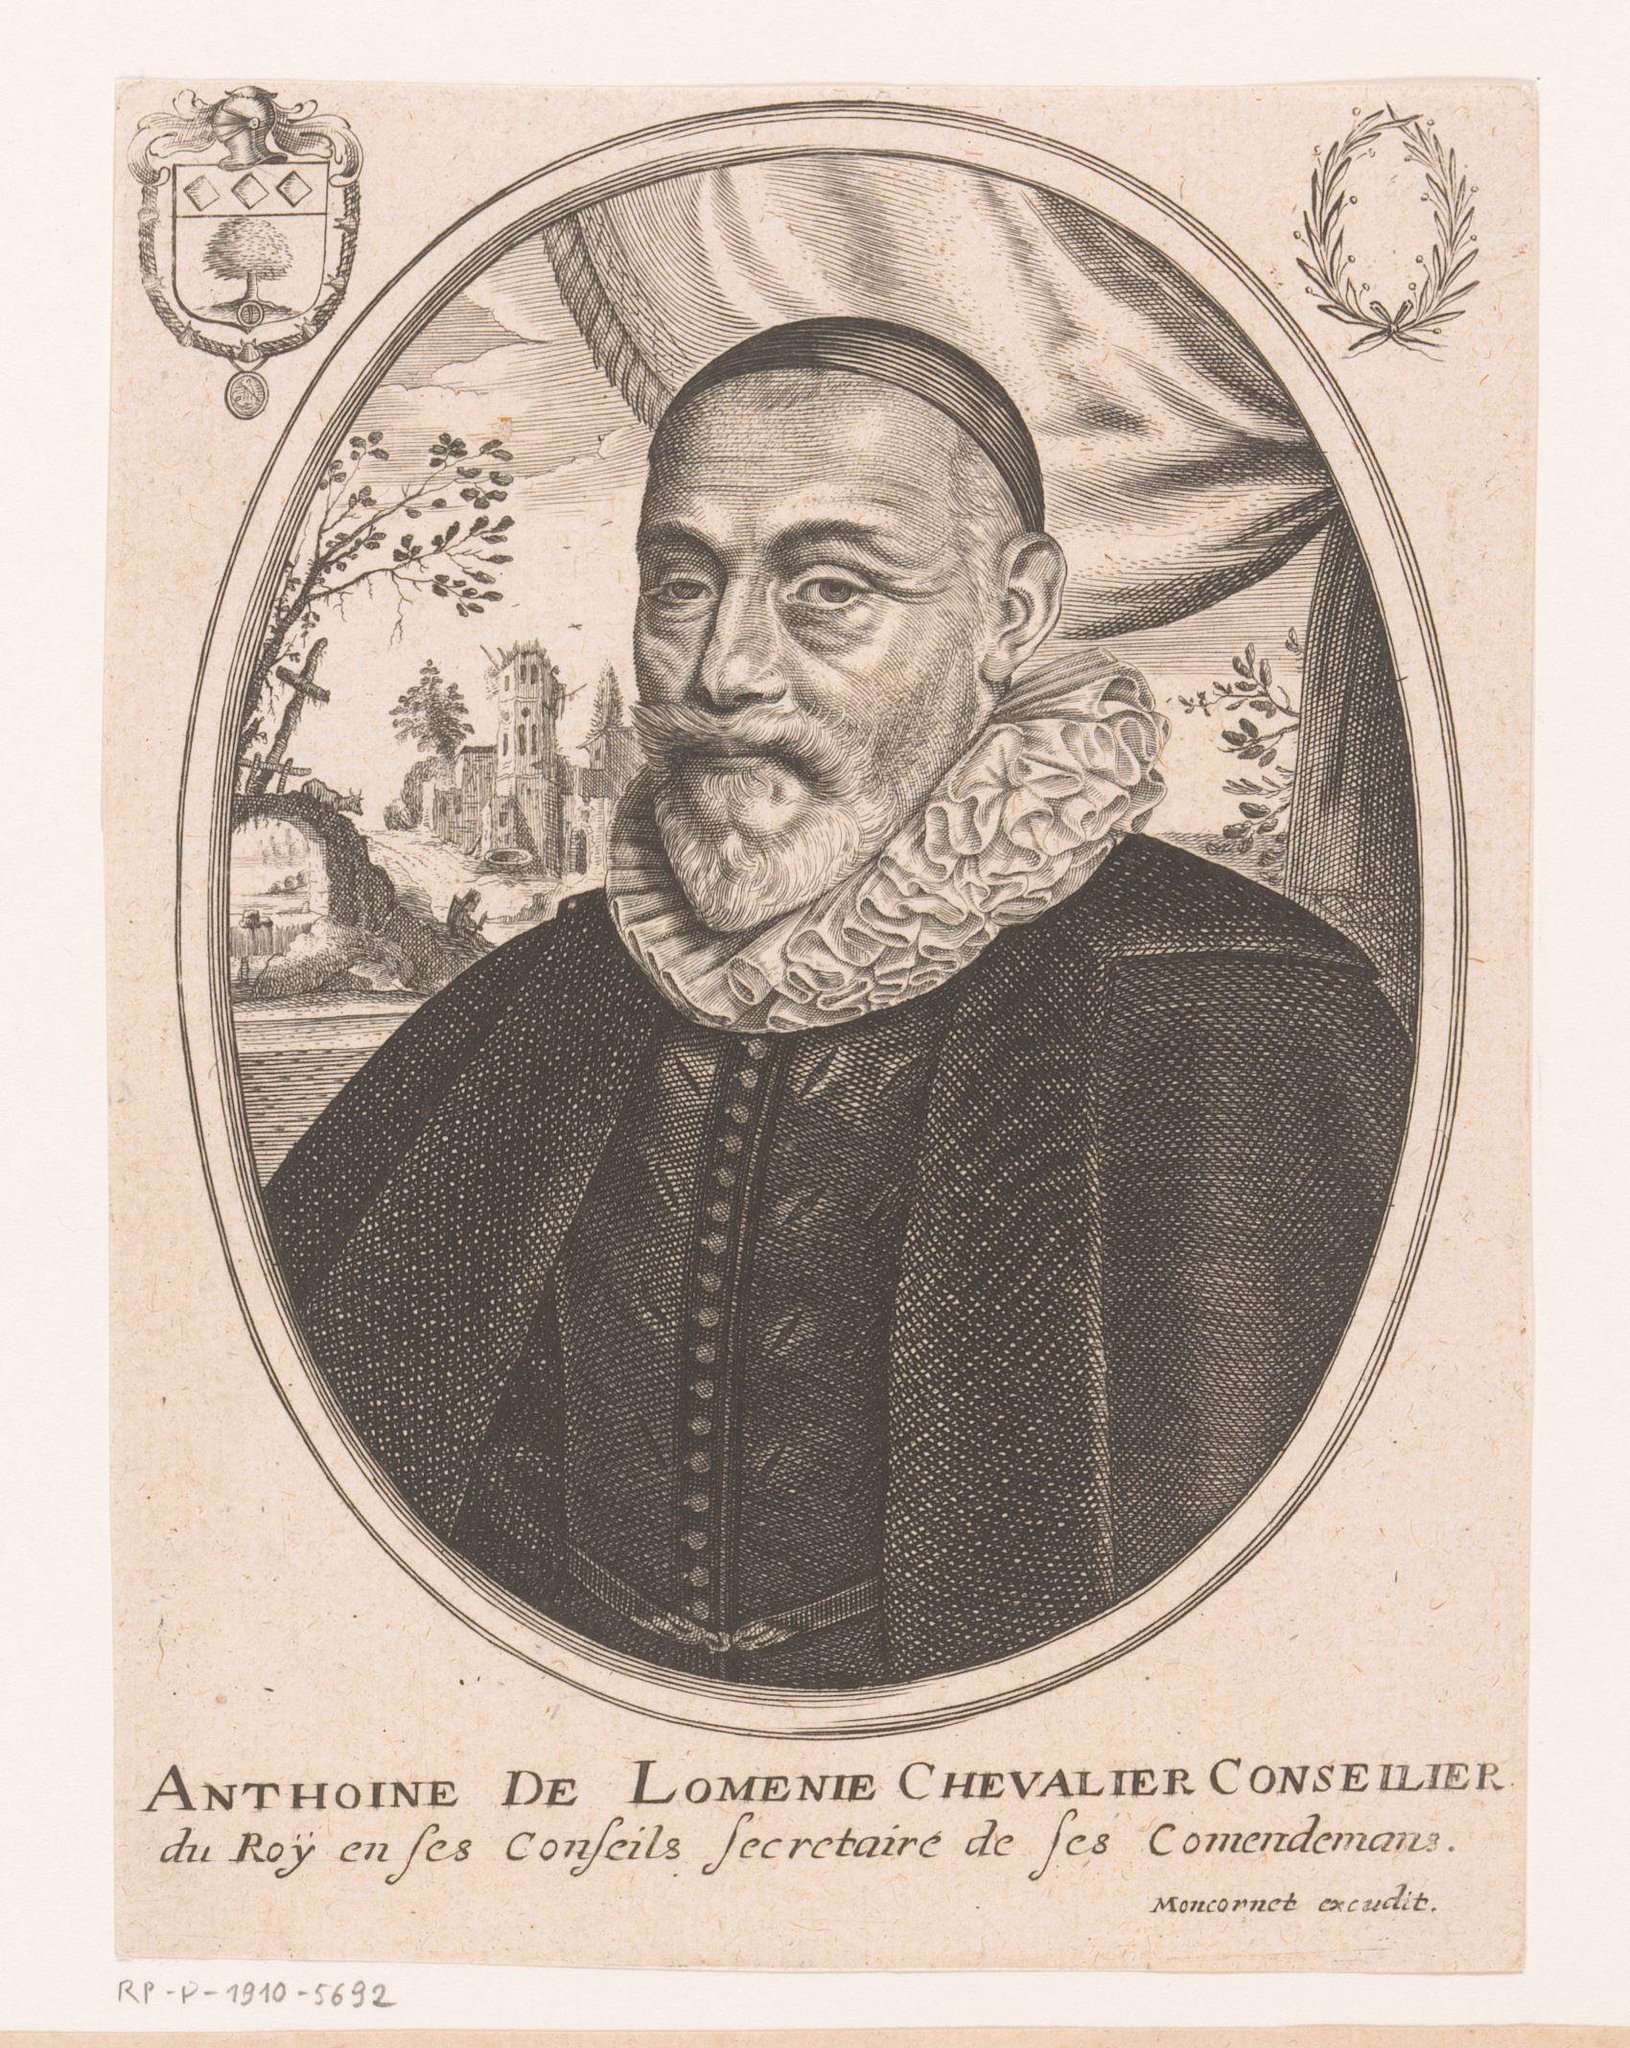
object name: print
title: Portret van Antoine de Loménie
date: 1610-1668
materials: paper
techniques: engraving, etching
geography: paris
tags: politician, historical persons, politician, e.g. party leader, armorial bearing, heraldry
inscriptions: collector's mark: Lugt 2228